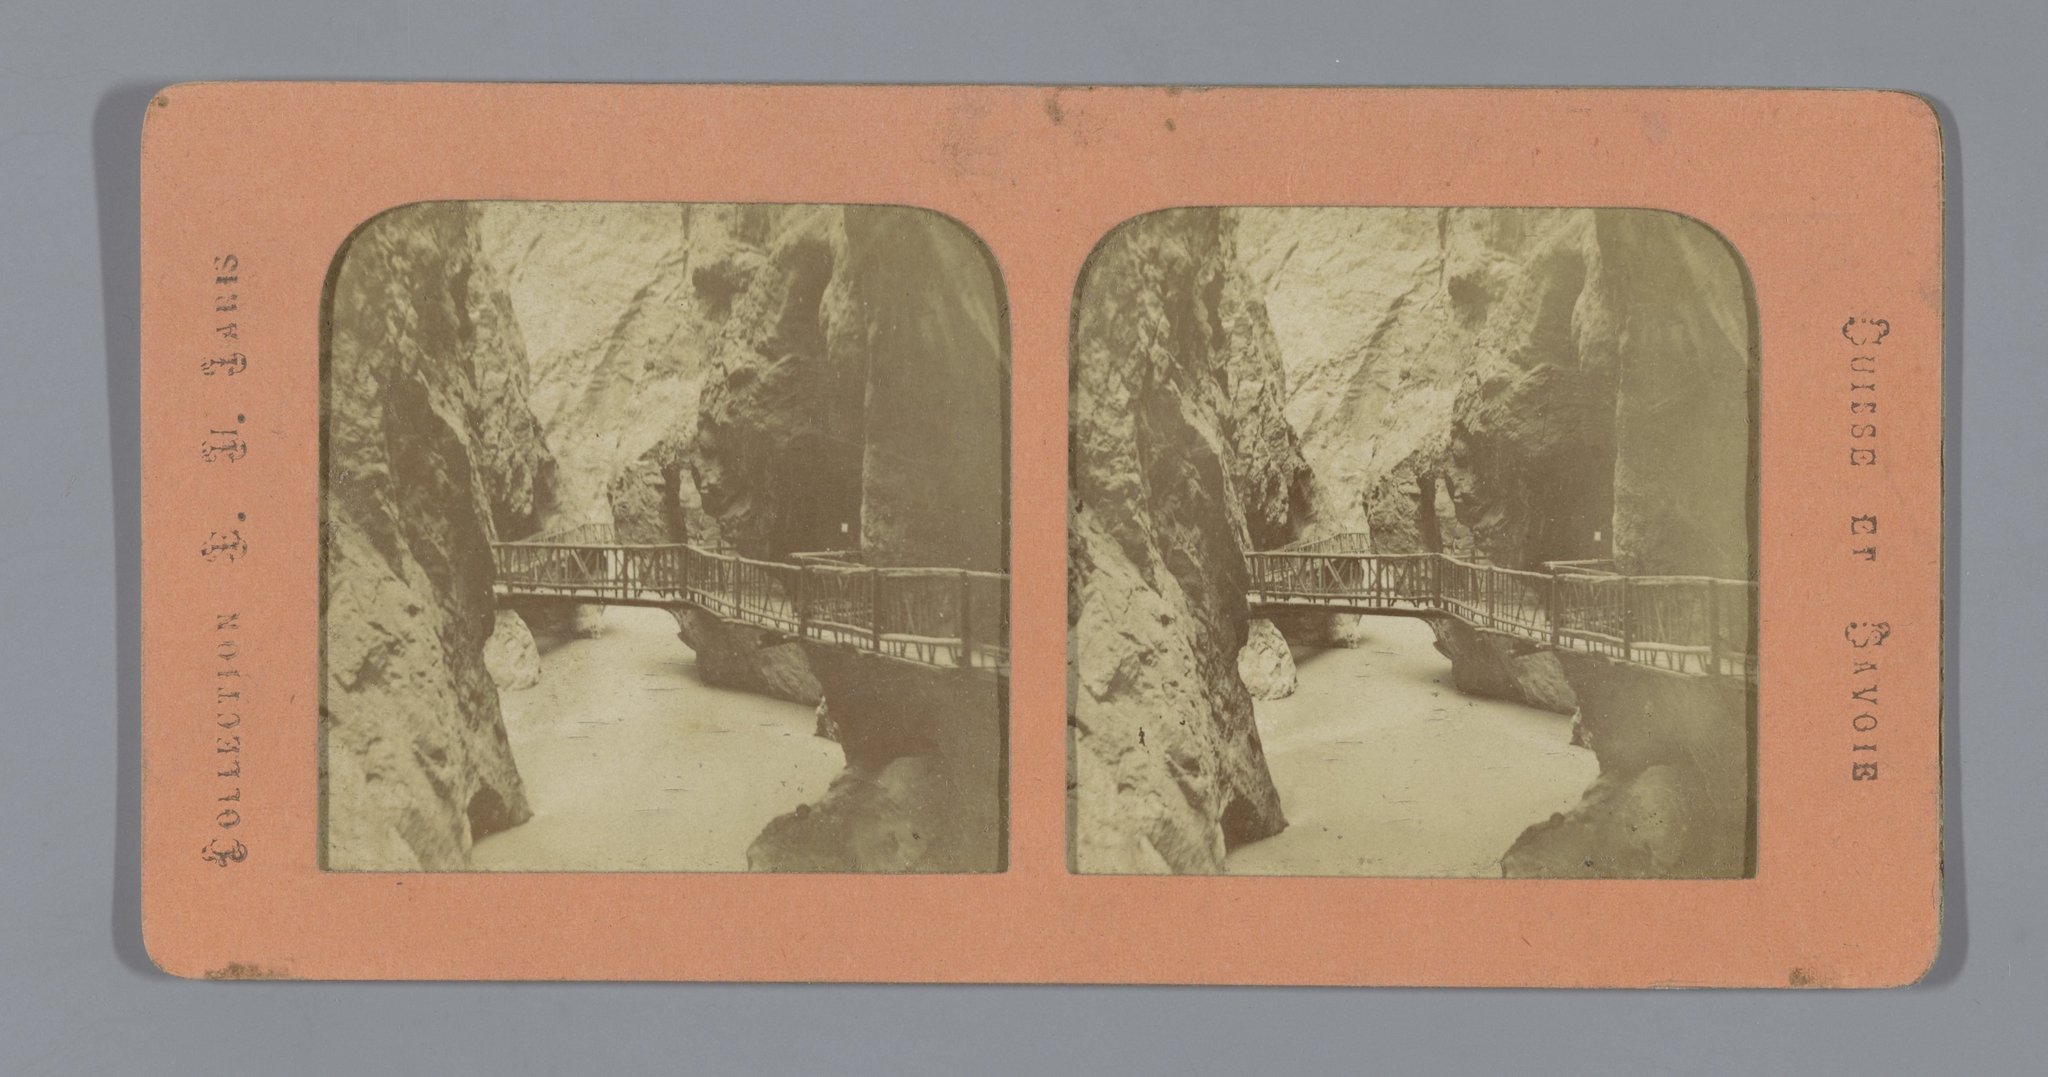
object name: tissue stereograph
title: Kloof van Trient, Zwitserland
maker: eugène hanau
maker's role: publisher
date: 1880-1882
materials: cardboard, paper, photographic support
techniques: albumen print, cutting, hand coloring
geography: trent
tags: ravine, chasm, abyss, canyon, brook